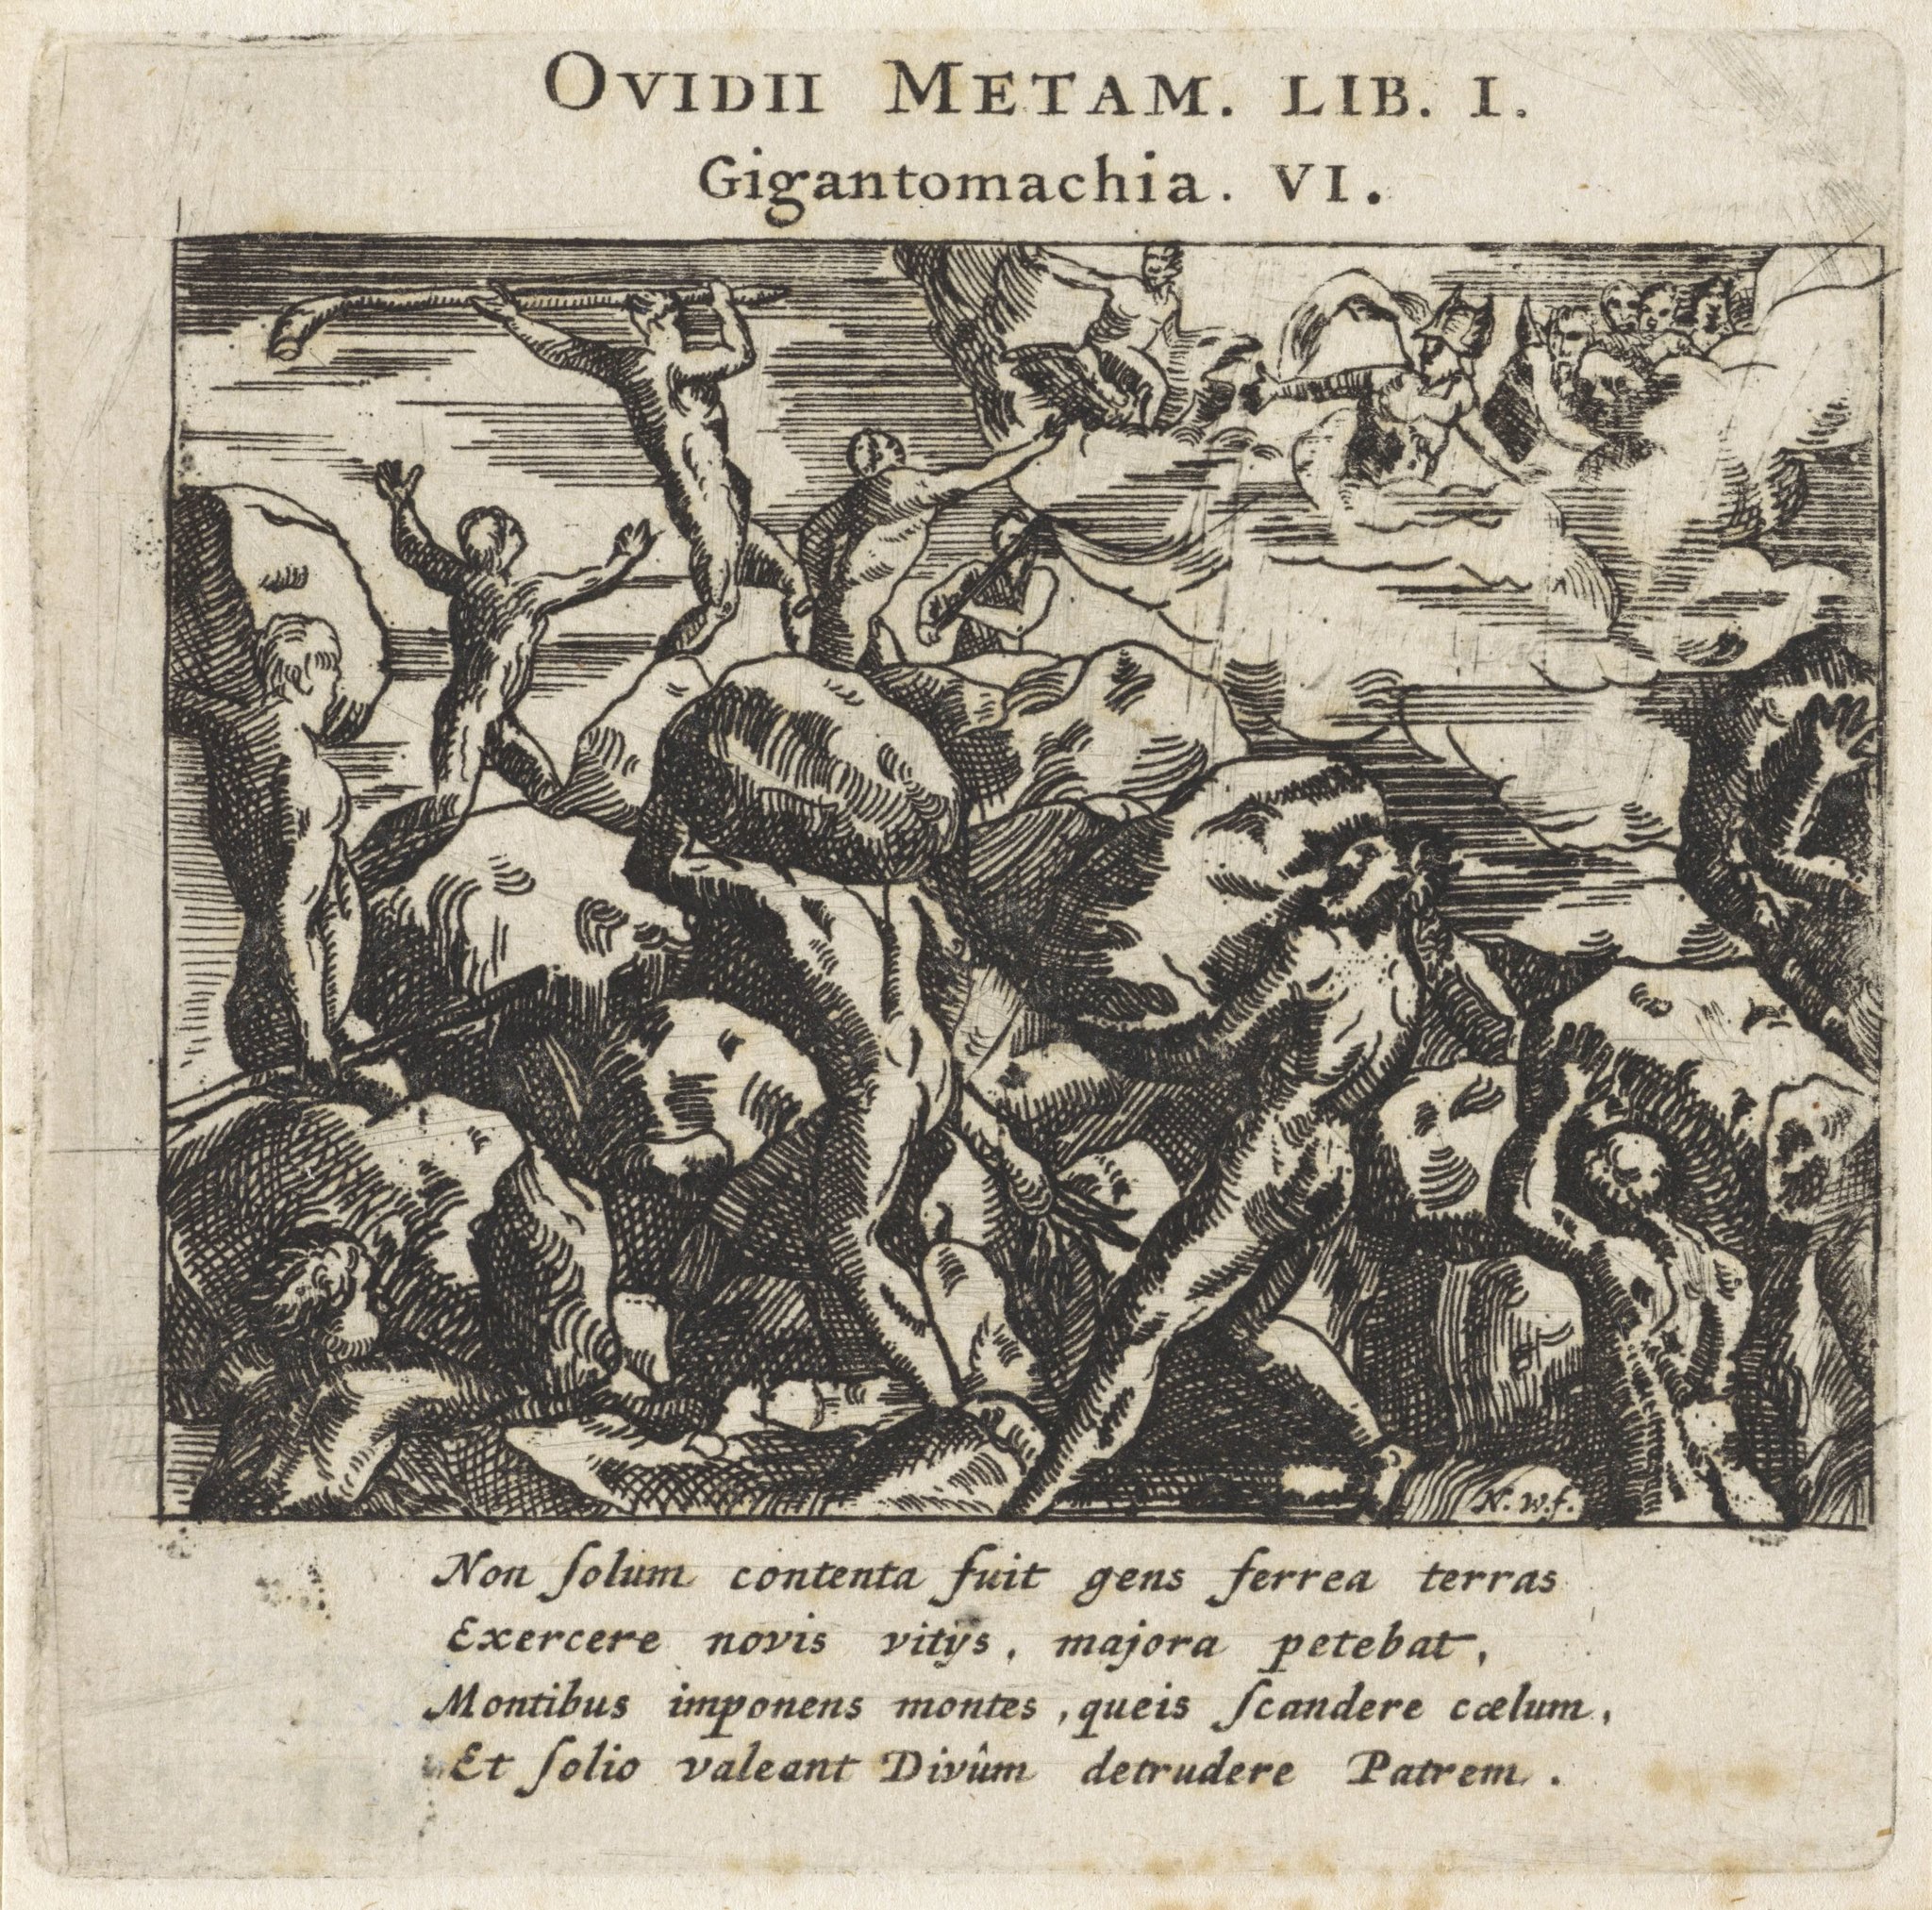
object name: print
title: Ovidii Metam. Lib. I Gigantomachia VI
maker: nicolaes cornelisz. witsen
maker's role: mayor, print maker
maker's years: 1641-1717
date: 1659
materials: paper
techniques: etching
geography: amsterdam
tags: battle of the giants against the gods: gigantomachy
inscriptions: collector's mark: Lugt 2165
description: Gigantomachie. Vooraan trekken Giganten met rotsblokken in de richting van de Olympische goden, die op een wolk zitten. Onder de voorstelling een vierregelige toelichting in het Latijn.